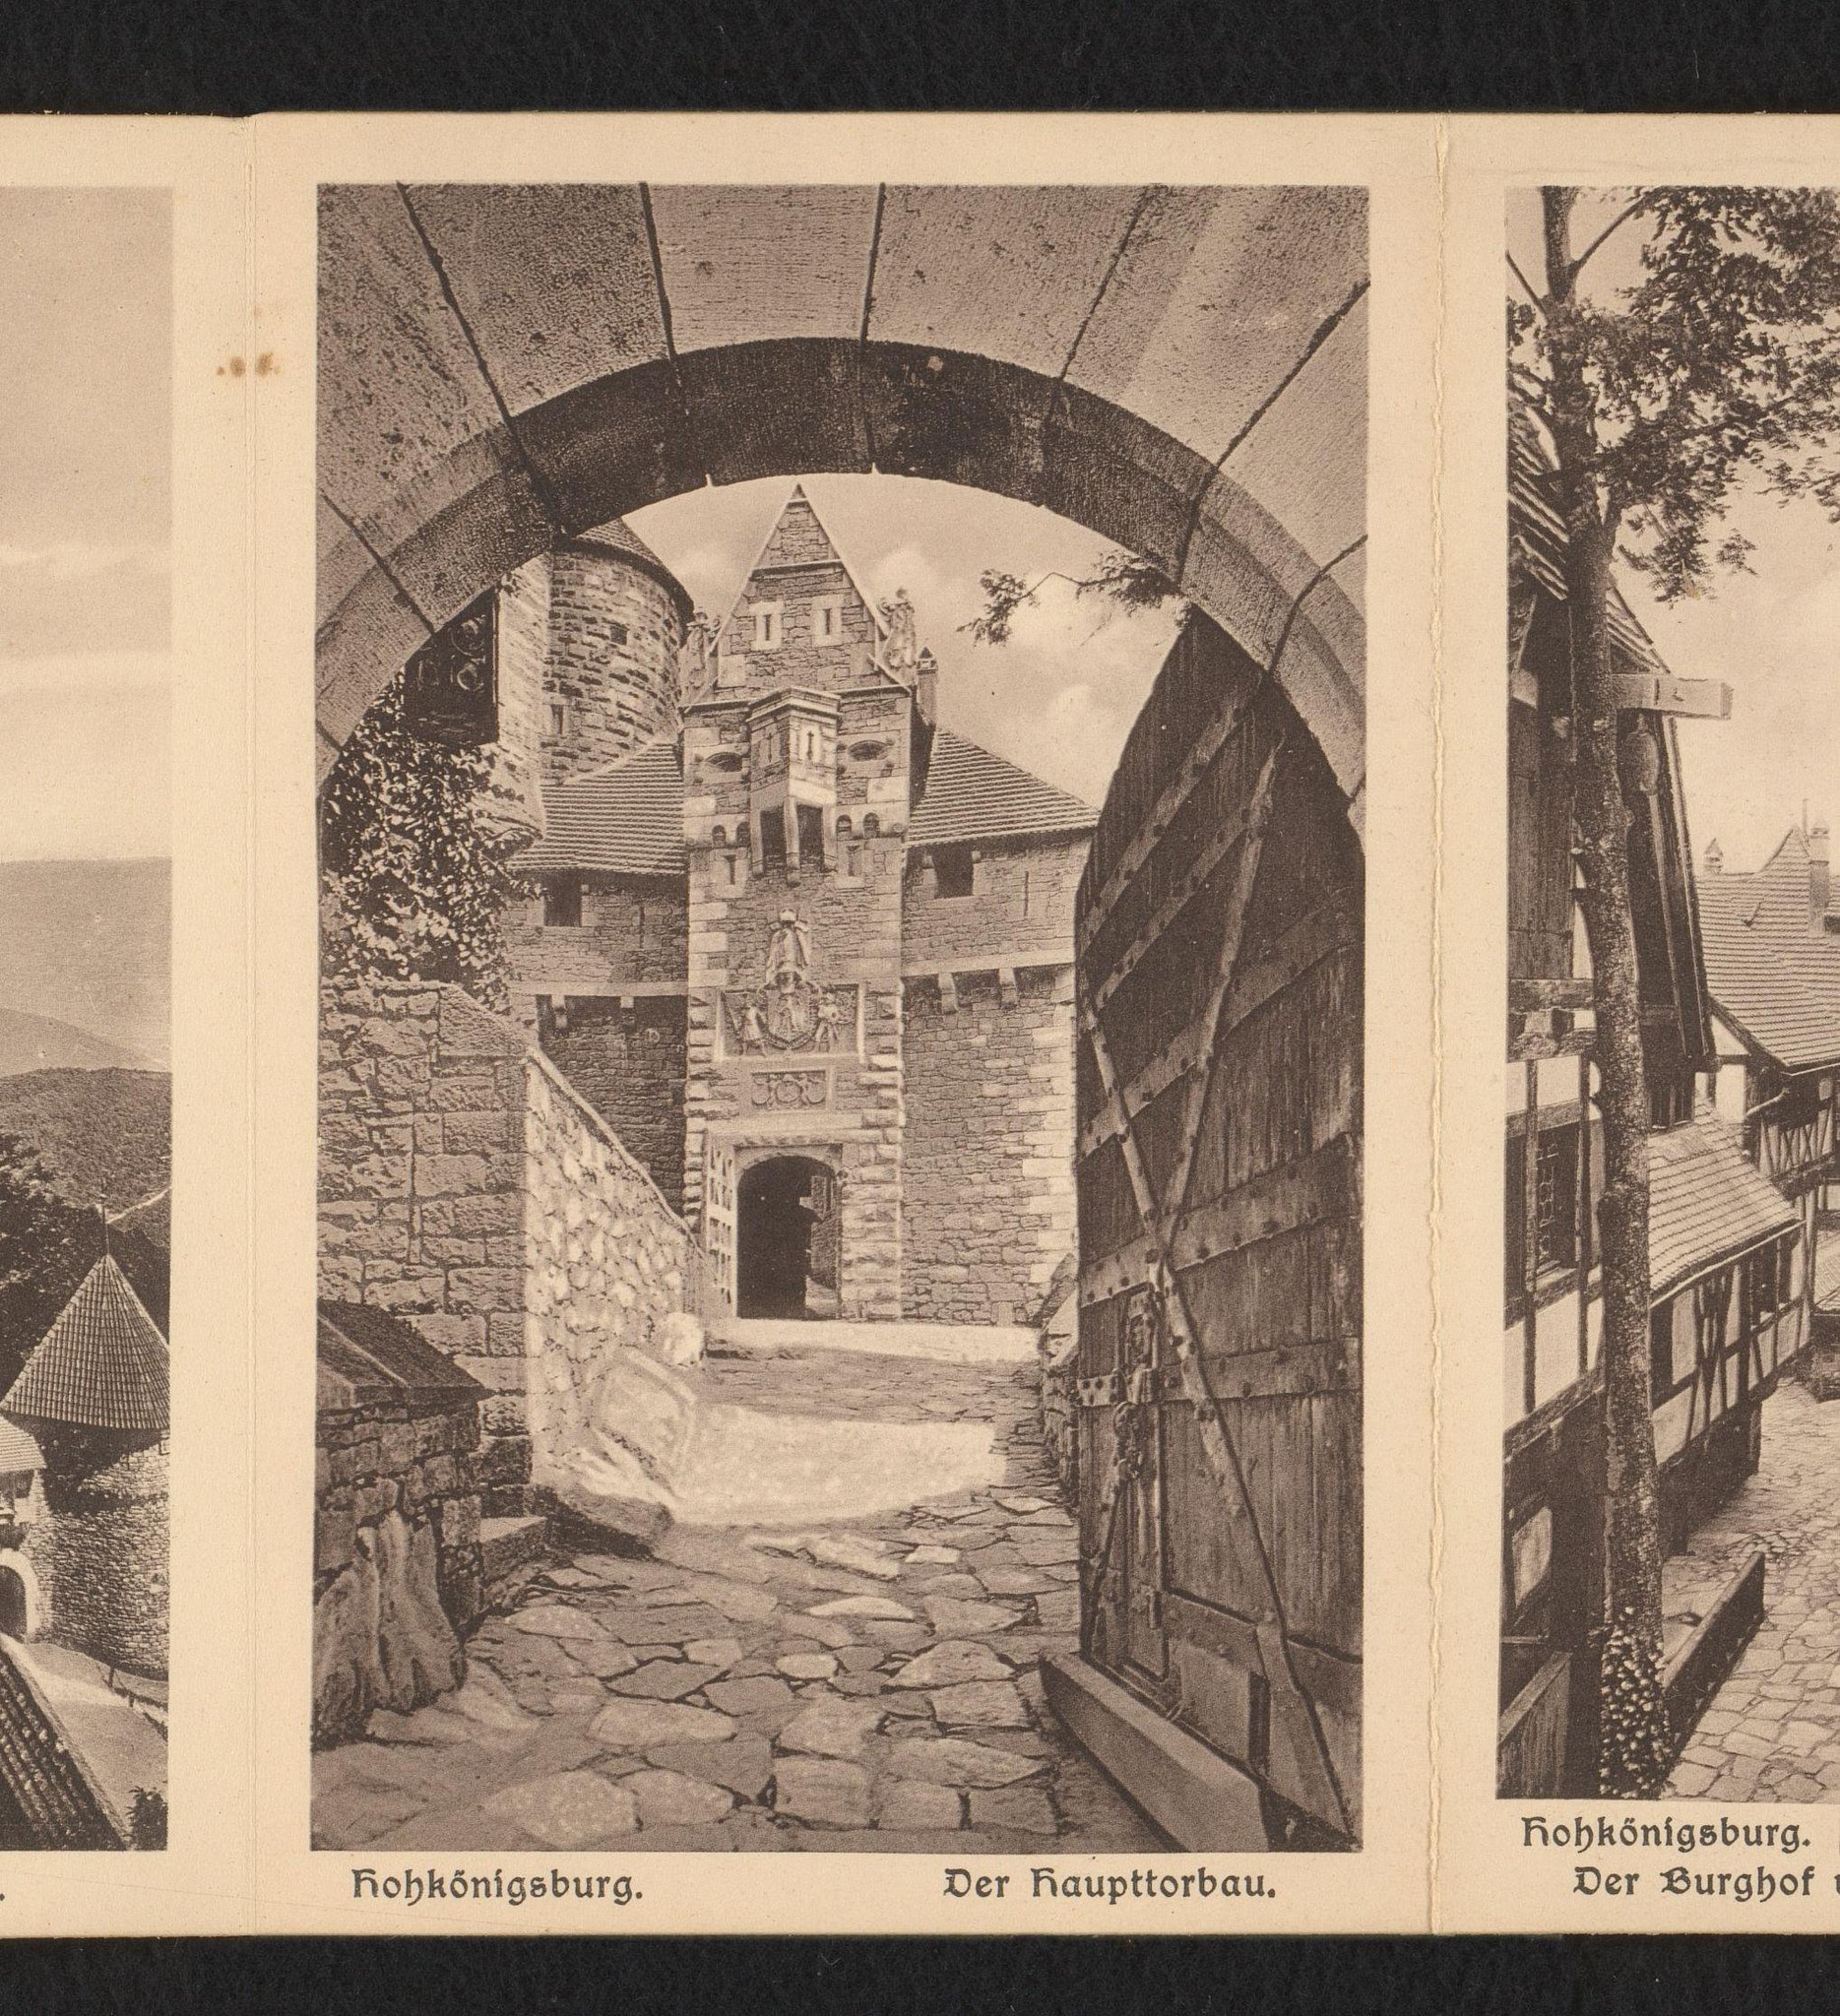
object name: photomechanical print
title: Hohkönigsburg. Der Haupttorbau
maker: Anonymous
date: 1908-1913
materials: cardboard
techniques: photograph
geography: alsace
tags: castle, gate, entrance